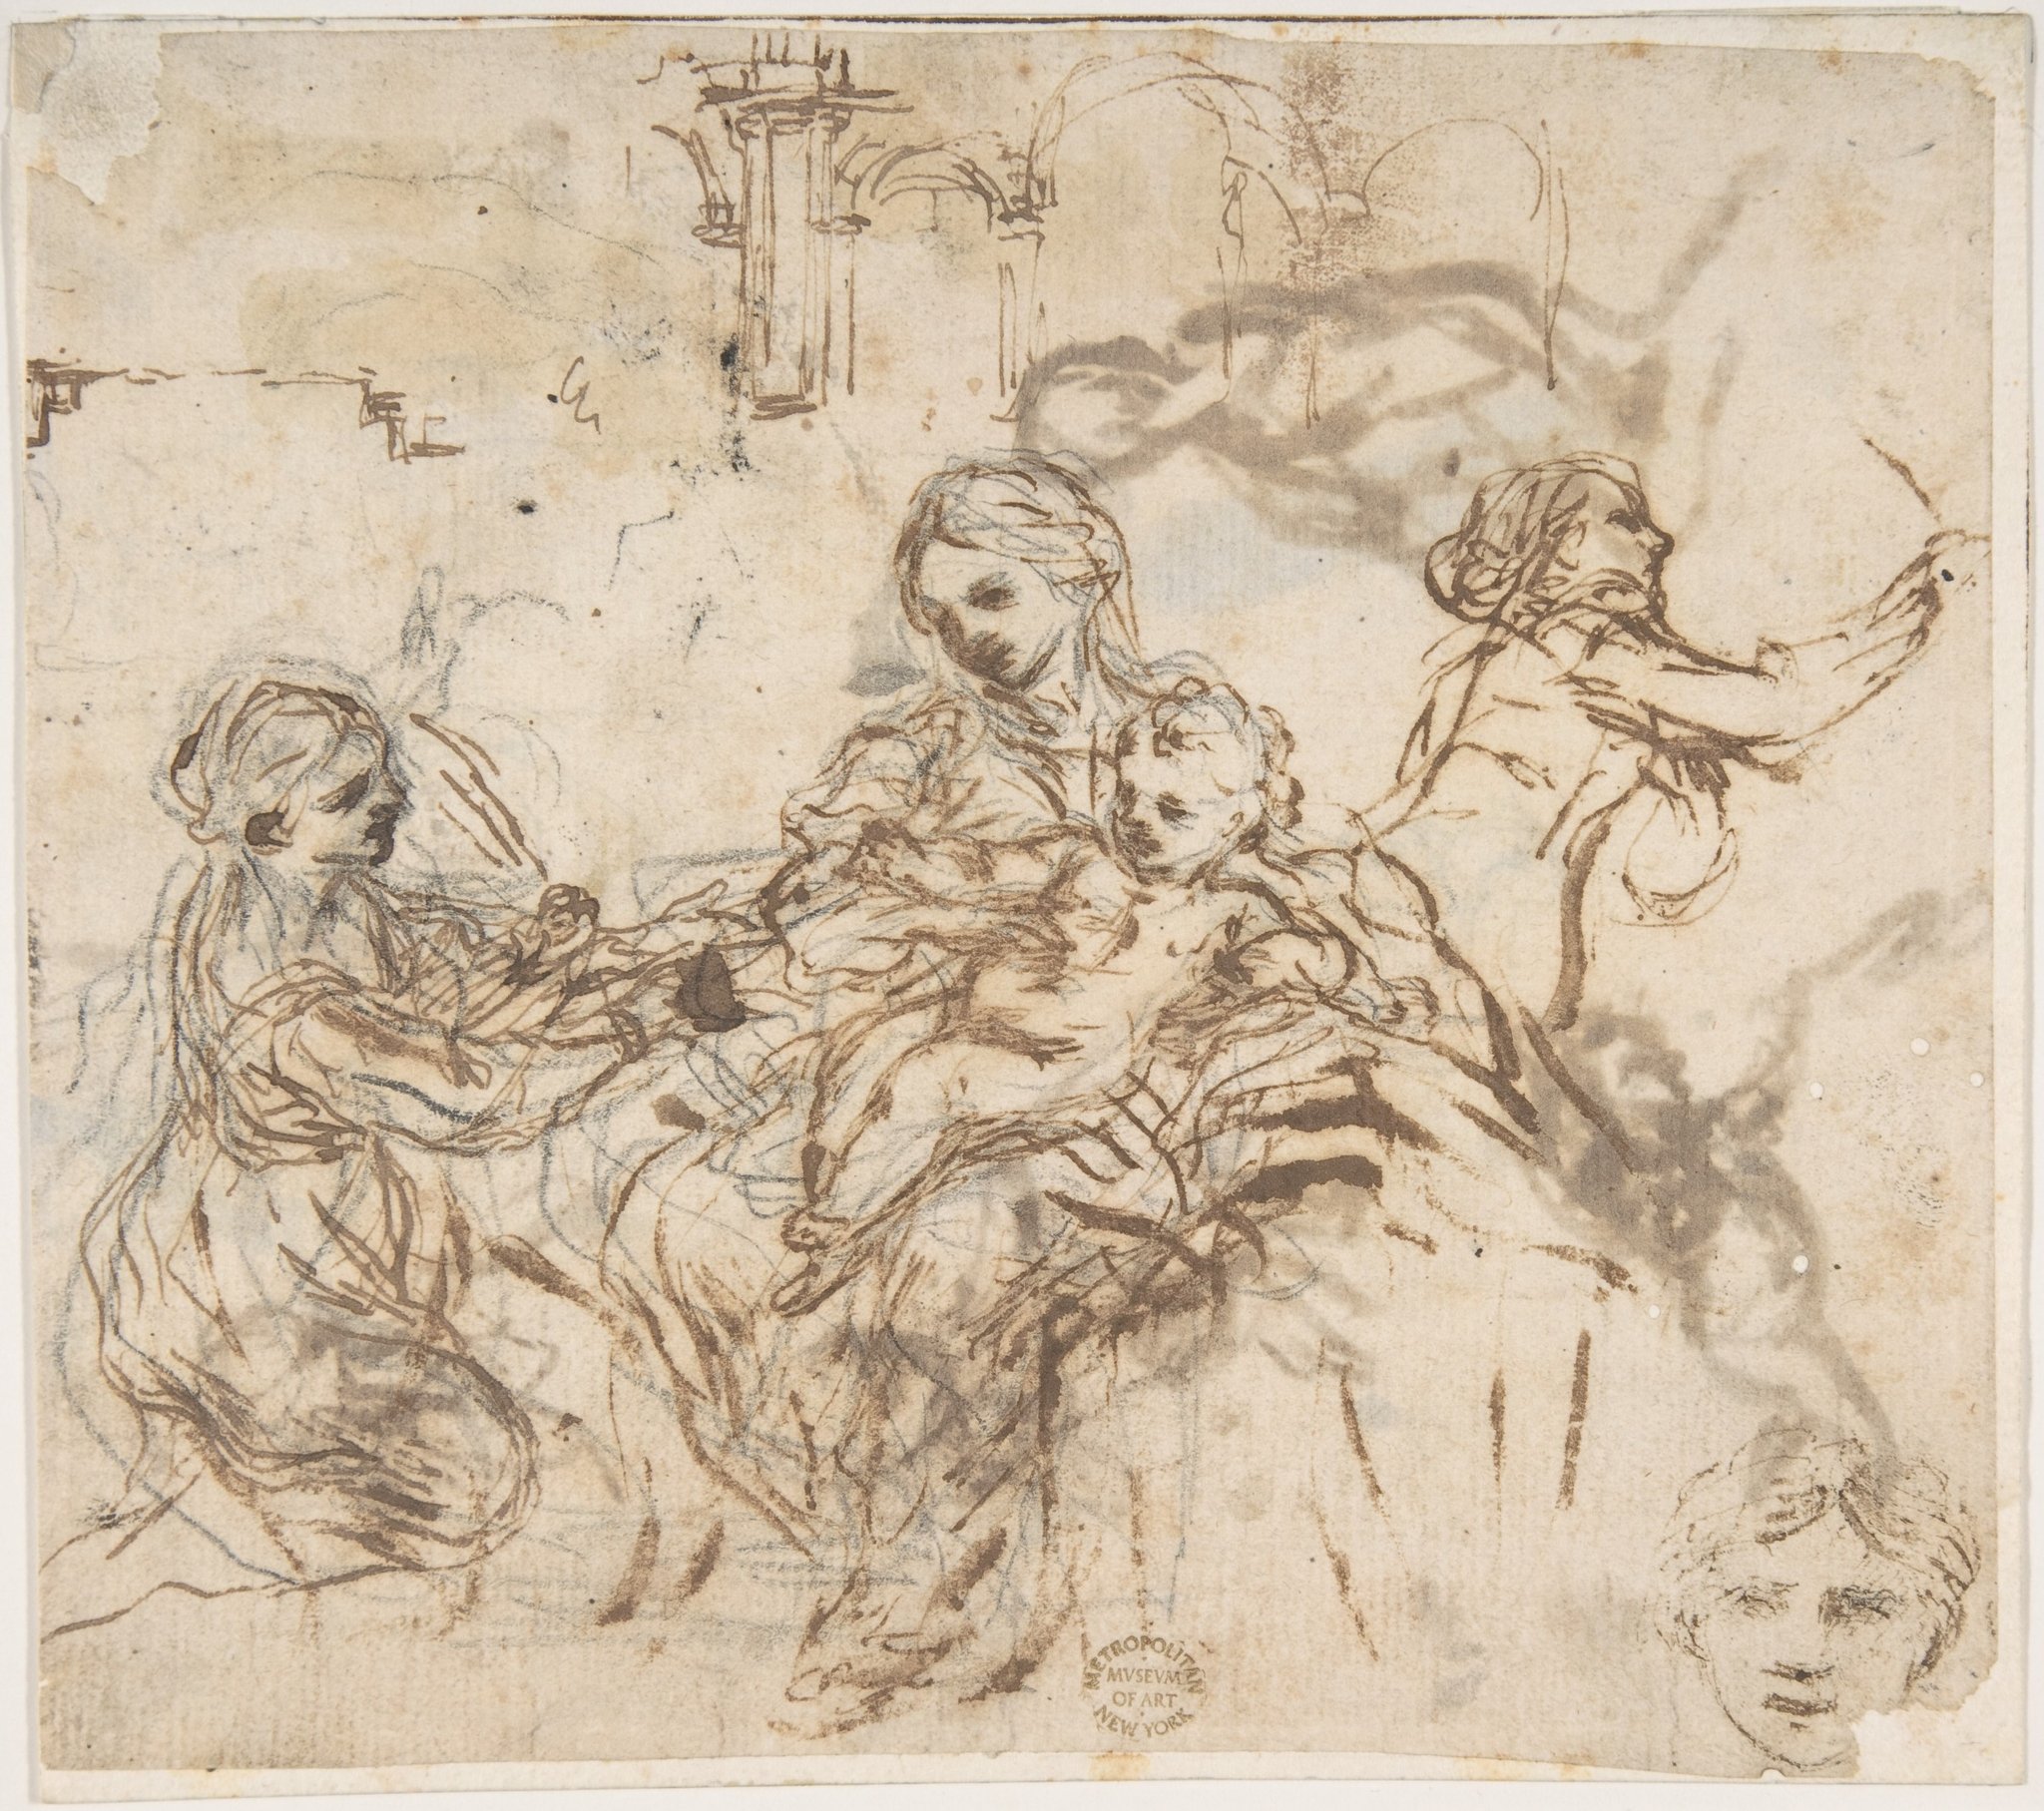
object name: drawing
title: The Virgin and Child with Saint Martina, Another Study of Saint Martina, Studies of a Head, and of an Arcade (recto); Figure Studies (verso)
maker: pietro da cortona (pietro berrettini)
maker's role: artist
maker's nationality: italian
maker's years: 1596-1669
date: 1596-1669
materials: chalk, ink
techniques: pen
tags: madonna and child,saints